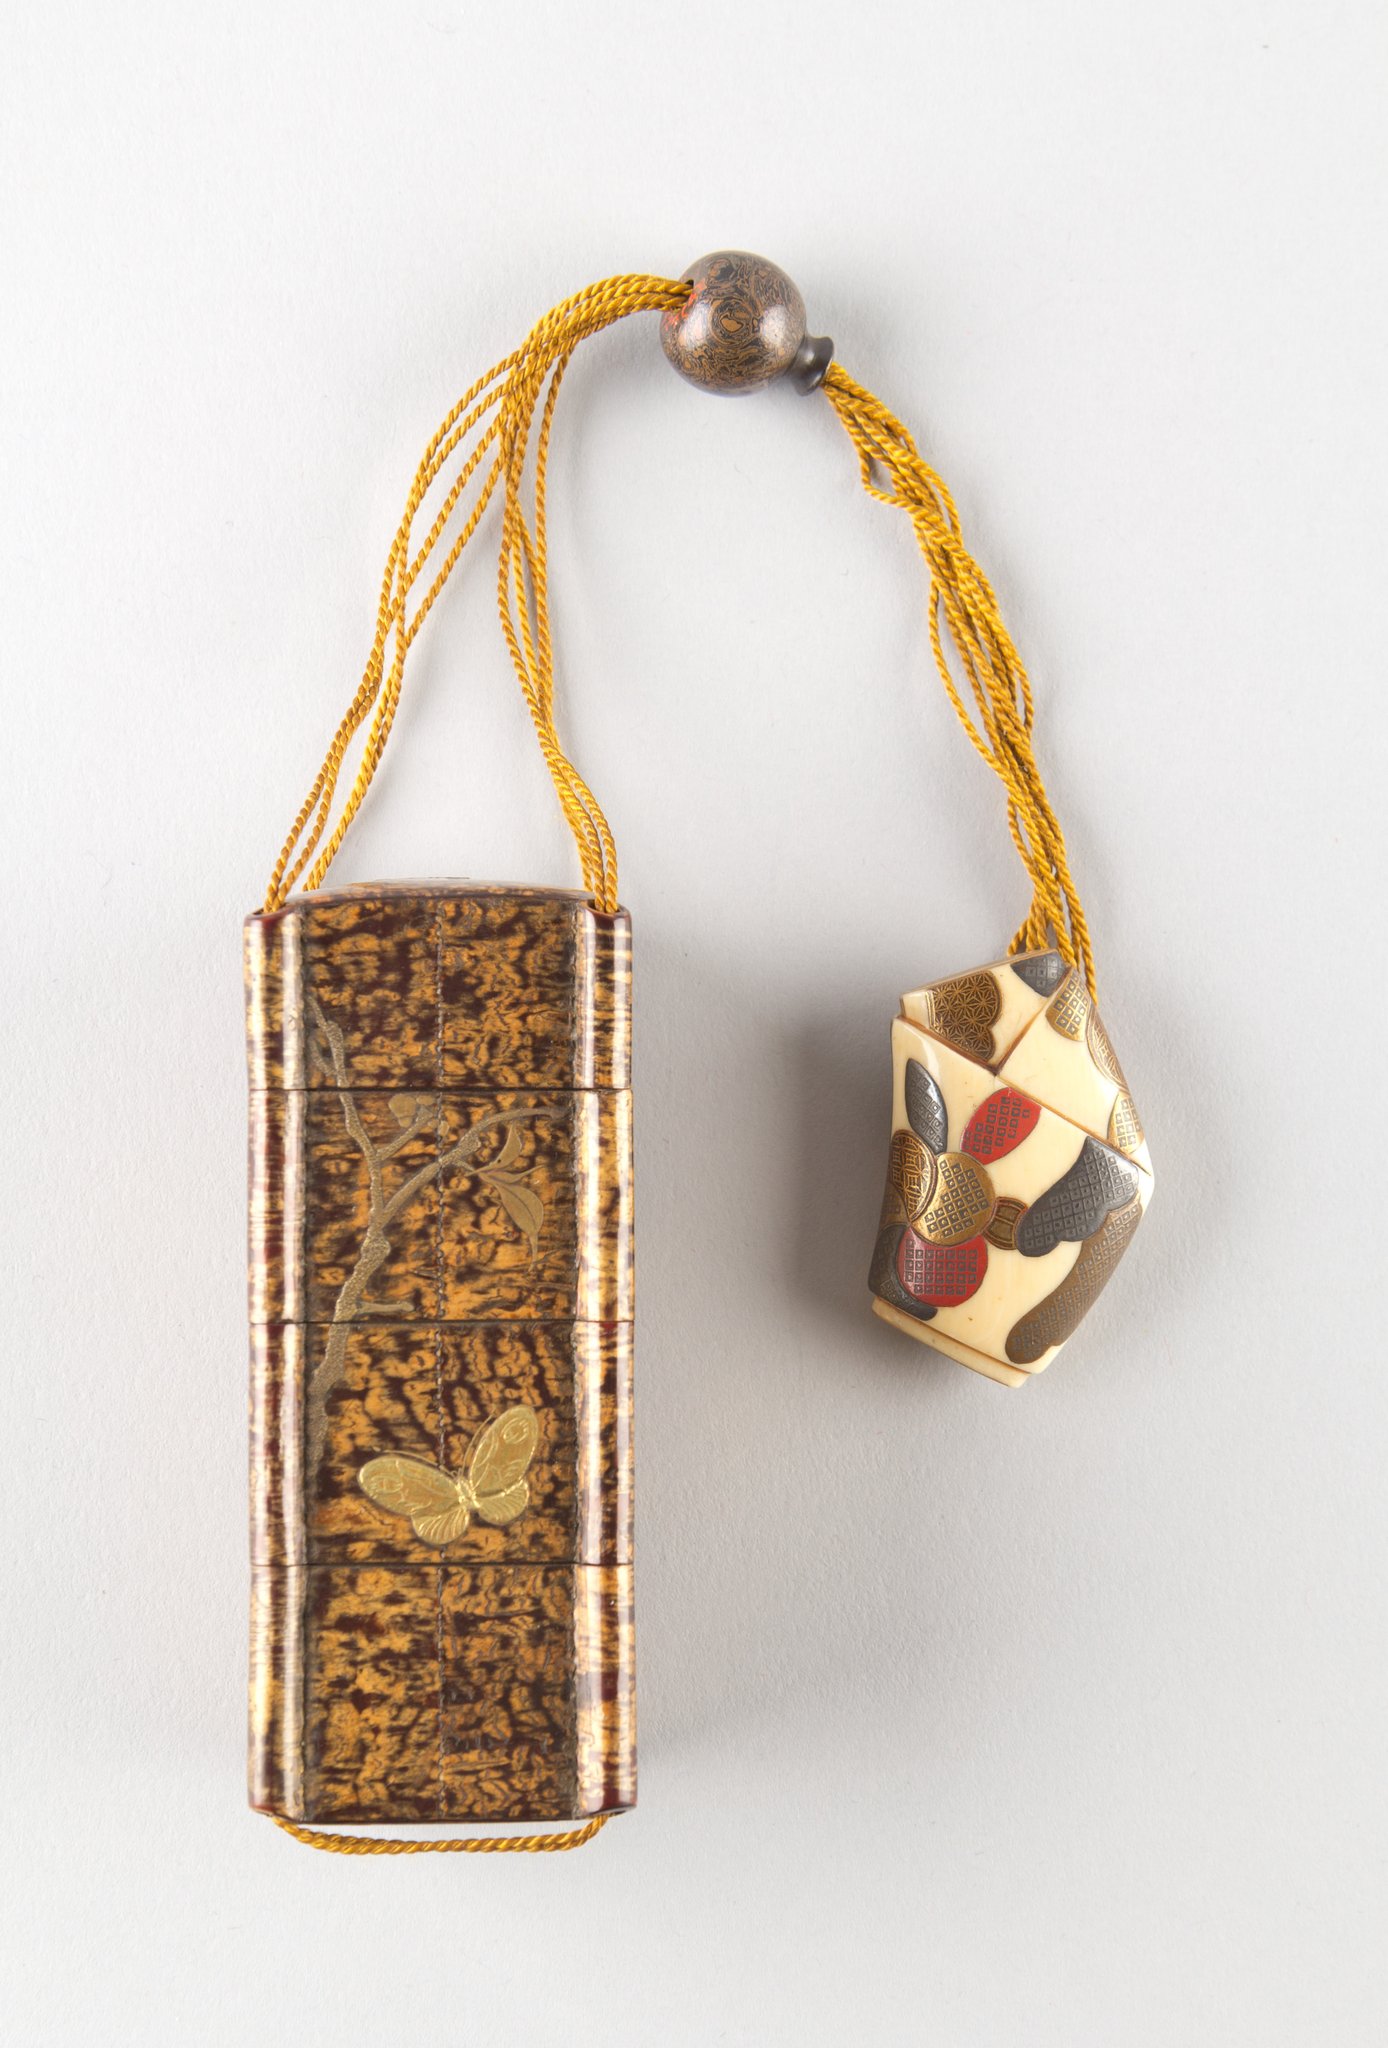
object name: ojime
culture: japanese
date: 1801-1900